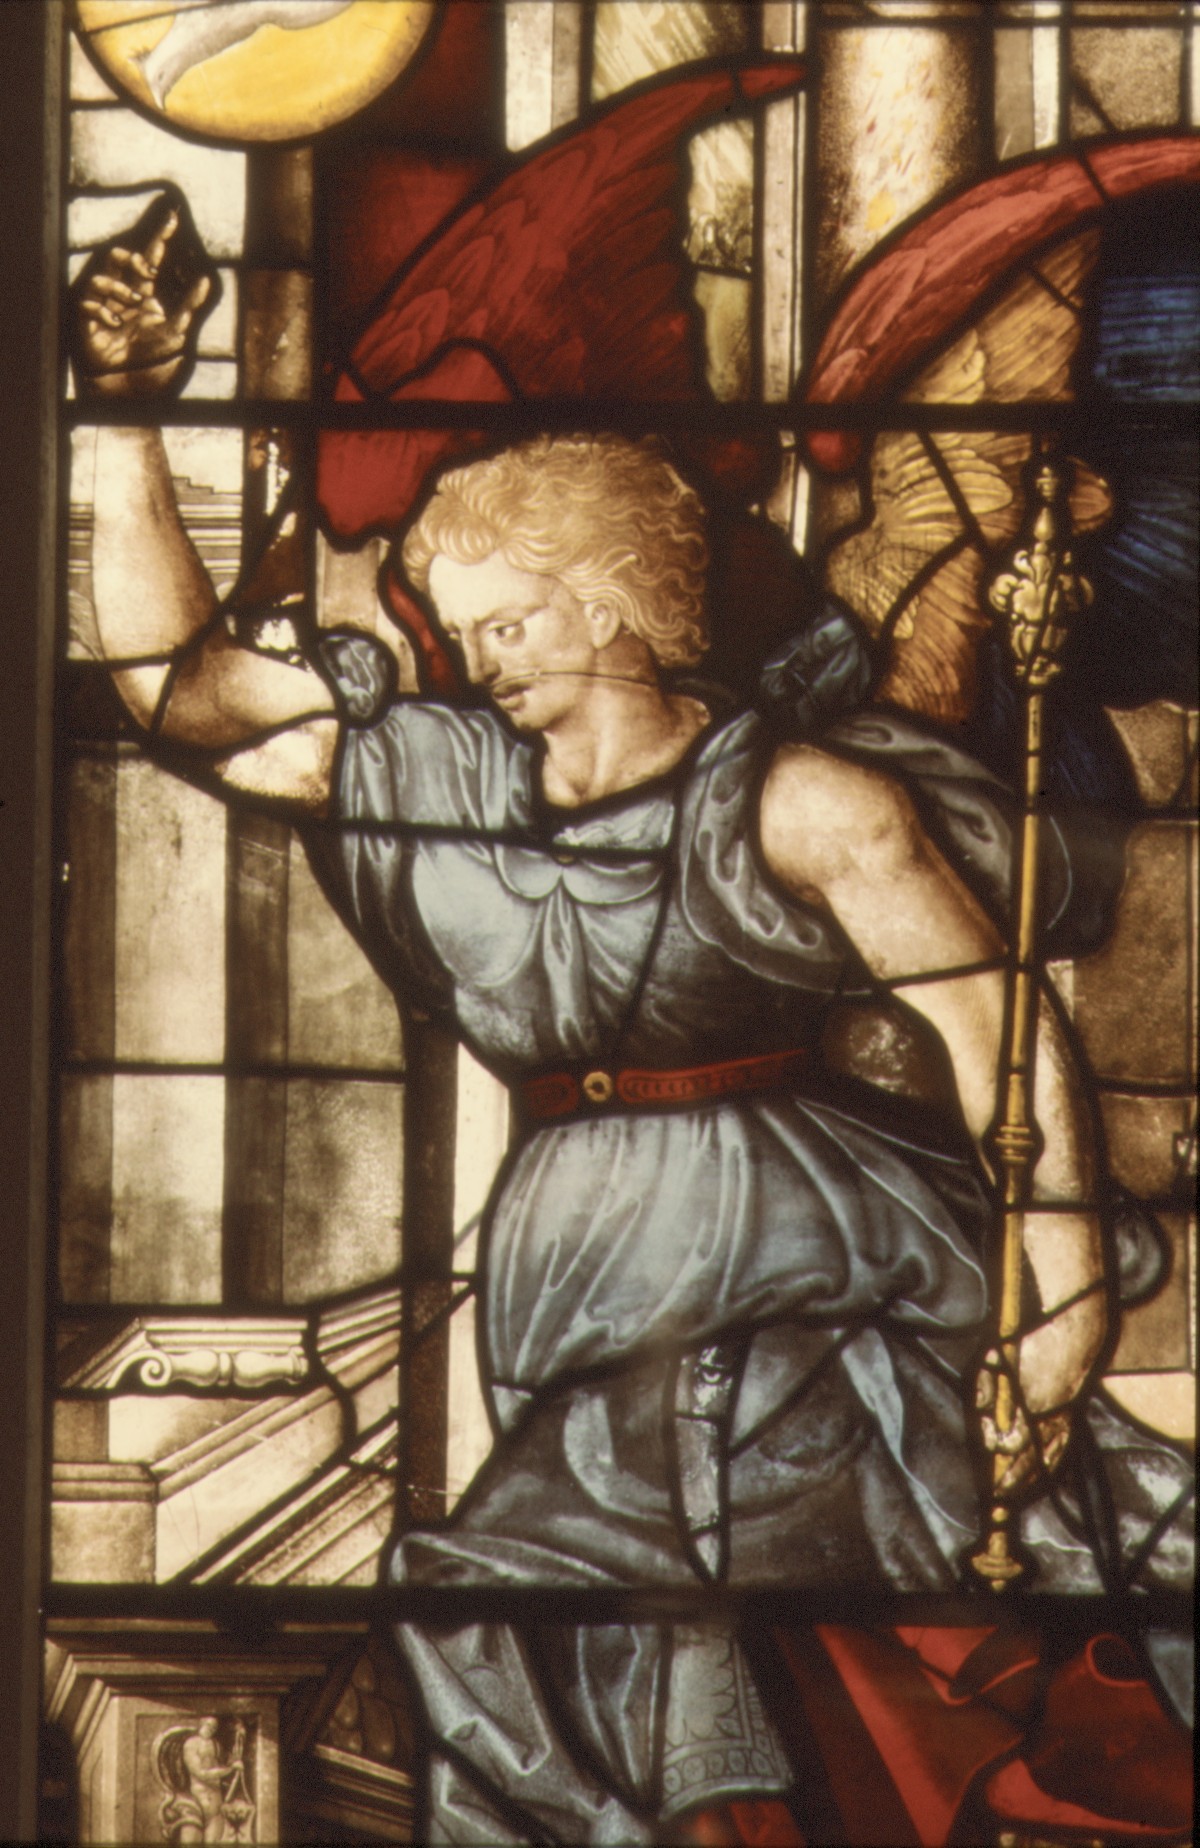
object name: panel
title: The Angel Gabriel (one of a pair)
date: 1552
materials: glass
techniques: enamel, stain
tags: archangel gabriel